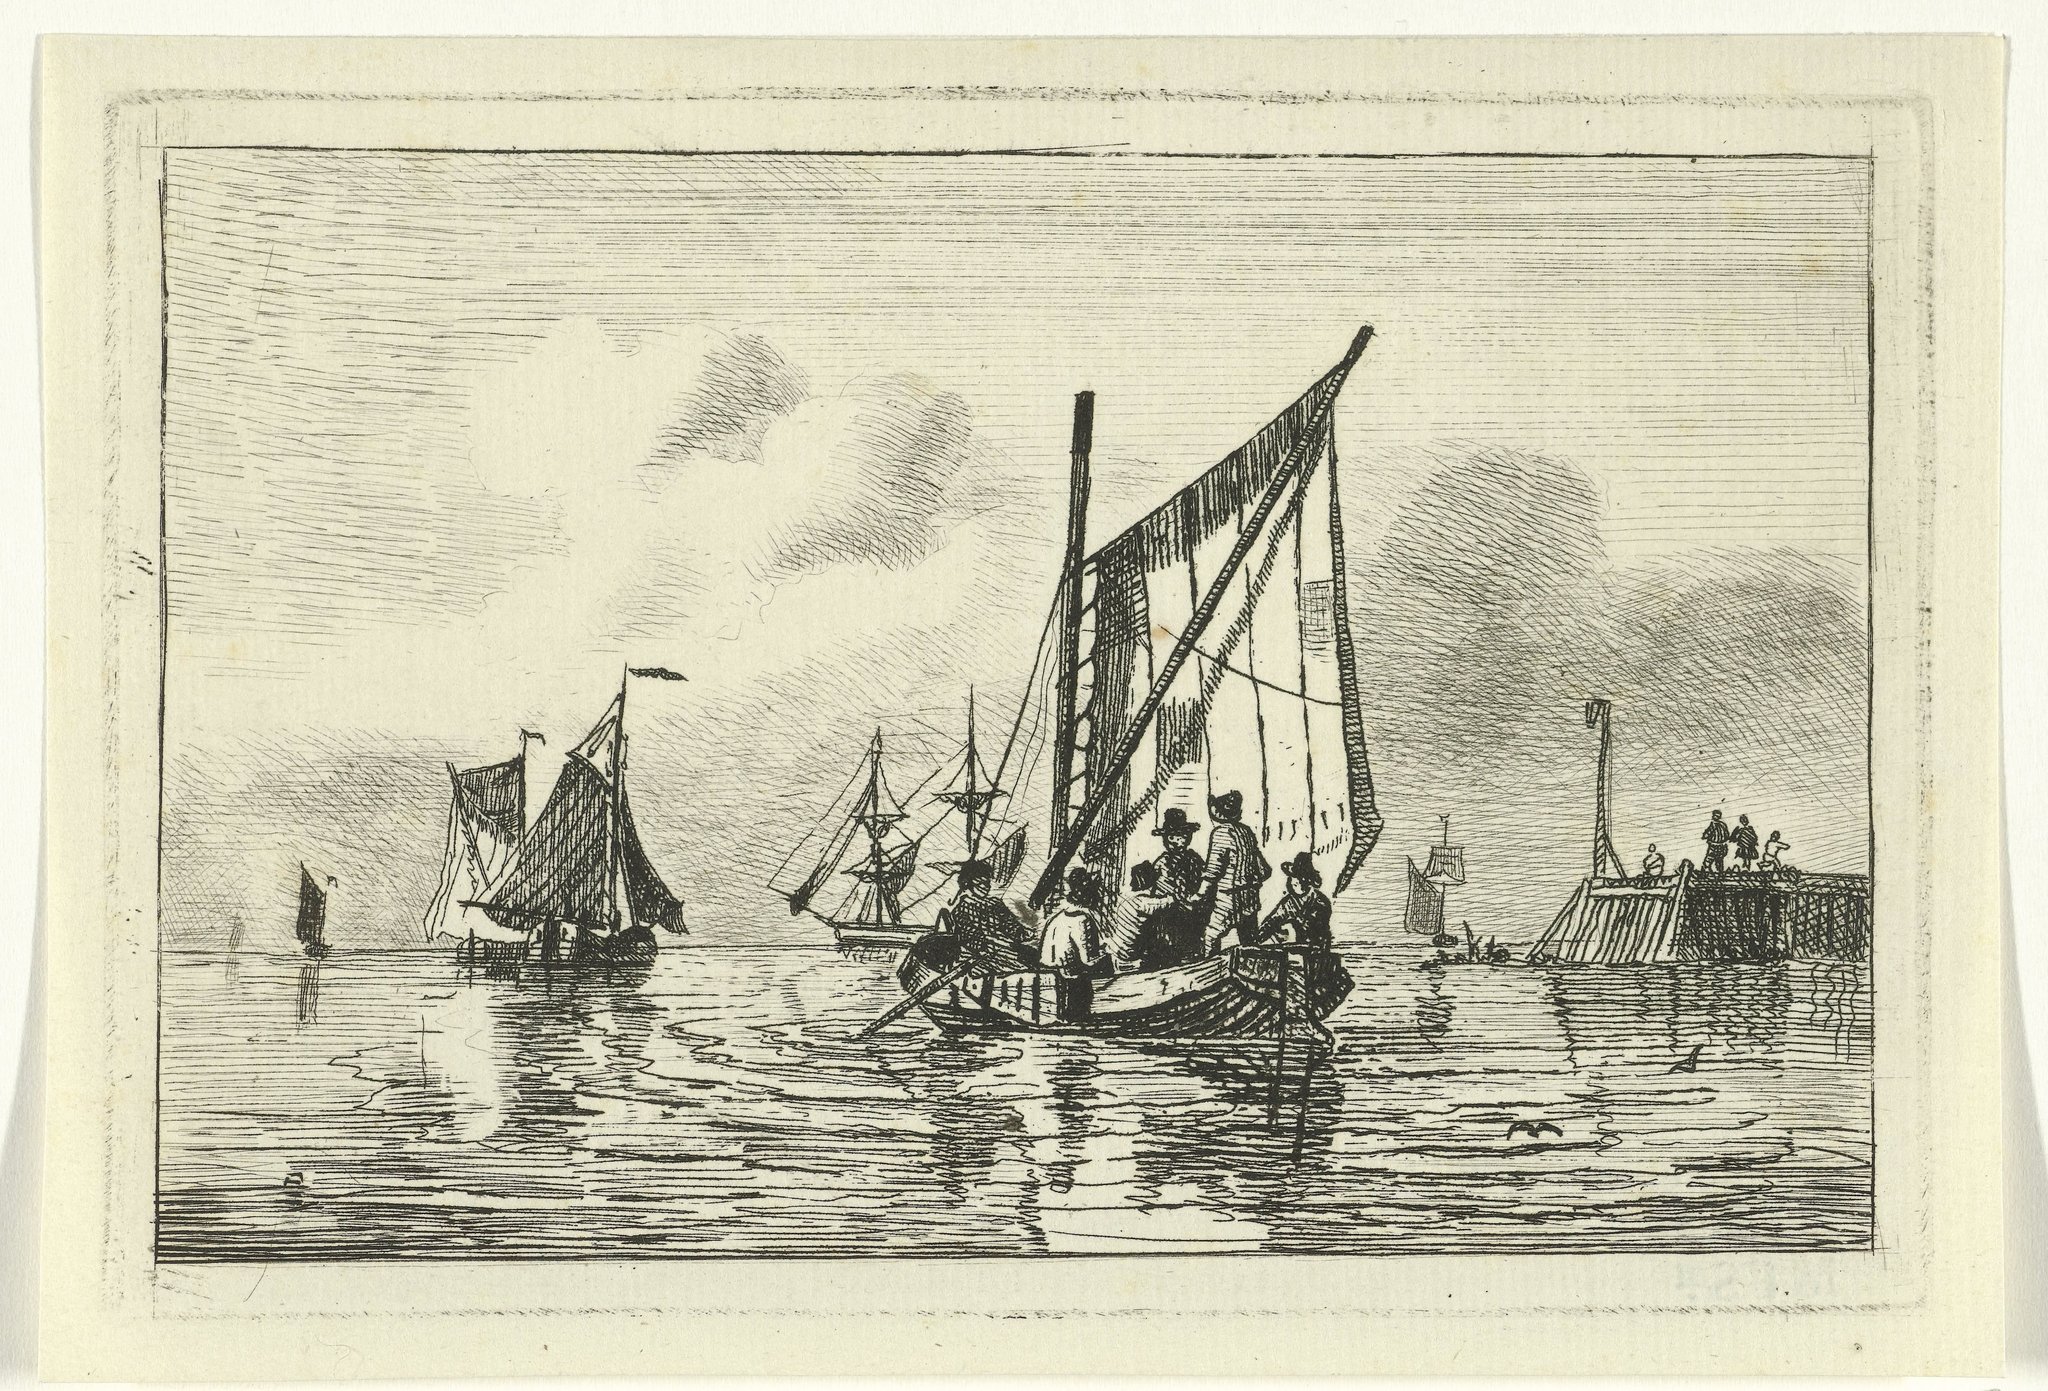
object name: print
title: Visserspink met zes mannen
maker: willem gruyter jr.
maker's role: draughtsman, print maker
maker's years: 1817-1880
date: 1832-1880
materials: paper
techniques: engraving, etching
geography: amsterdam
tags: rowing-boat, canoe, etc. (+ view ~ vehicle, ship, etc.)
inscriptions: collector's mark: Lugt 2165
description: Een visserspink met zes mannen, op de achtergrond zeilschepen, rechts een pier.